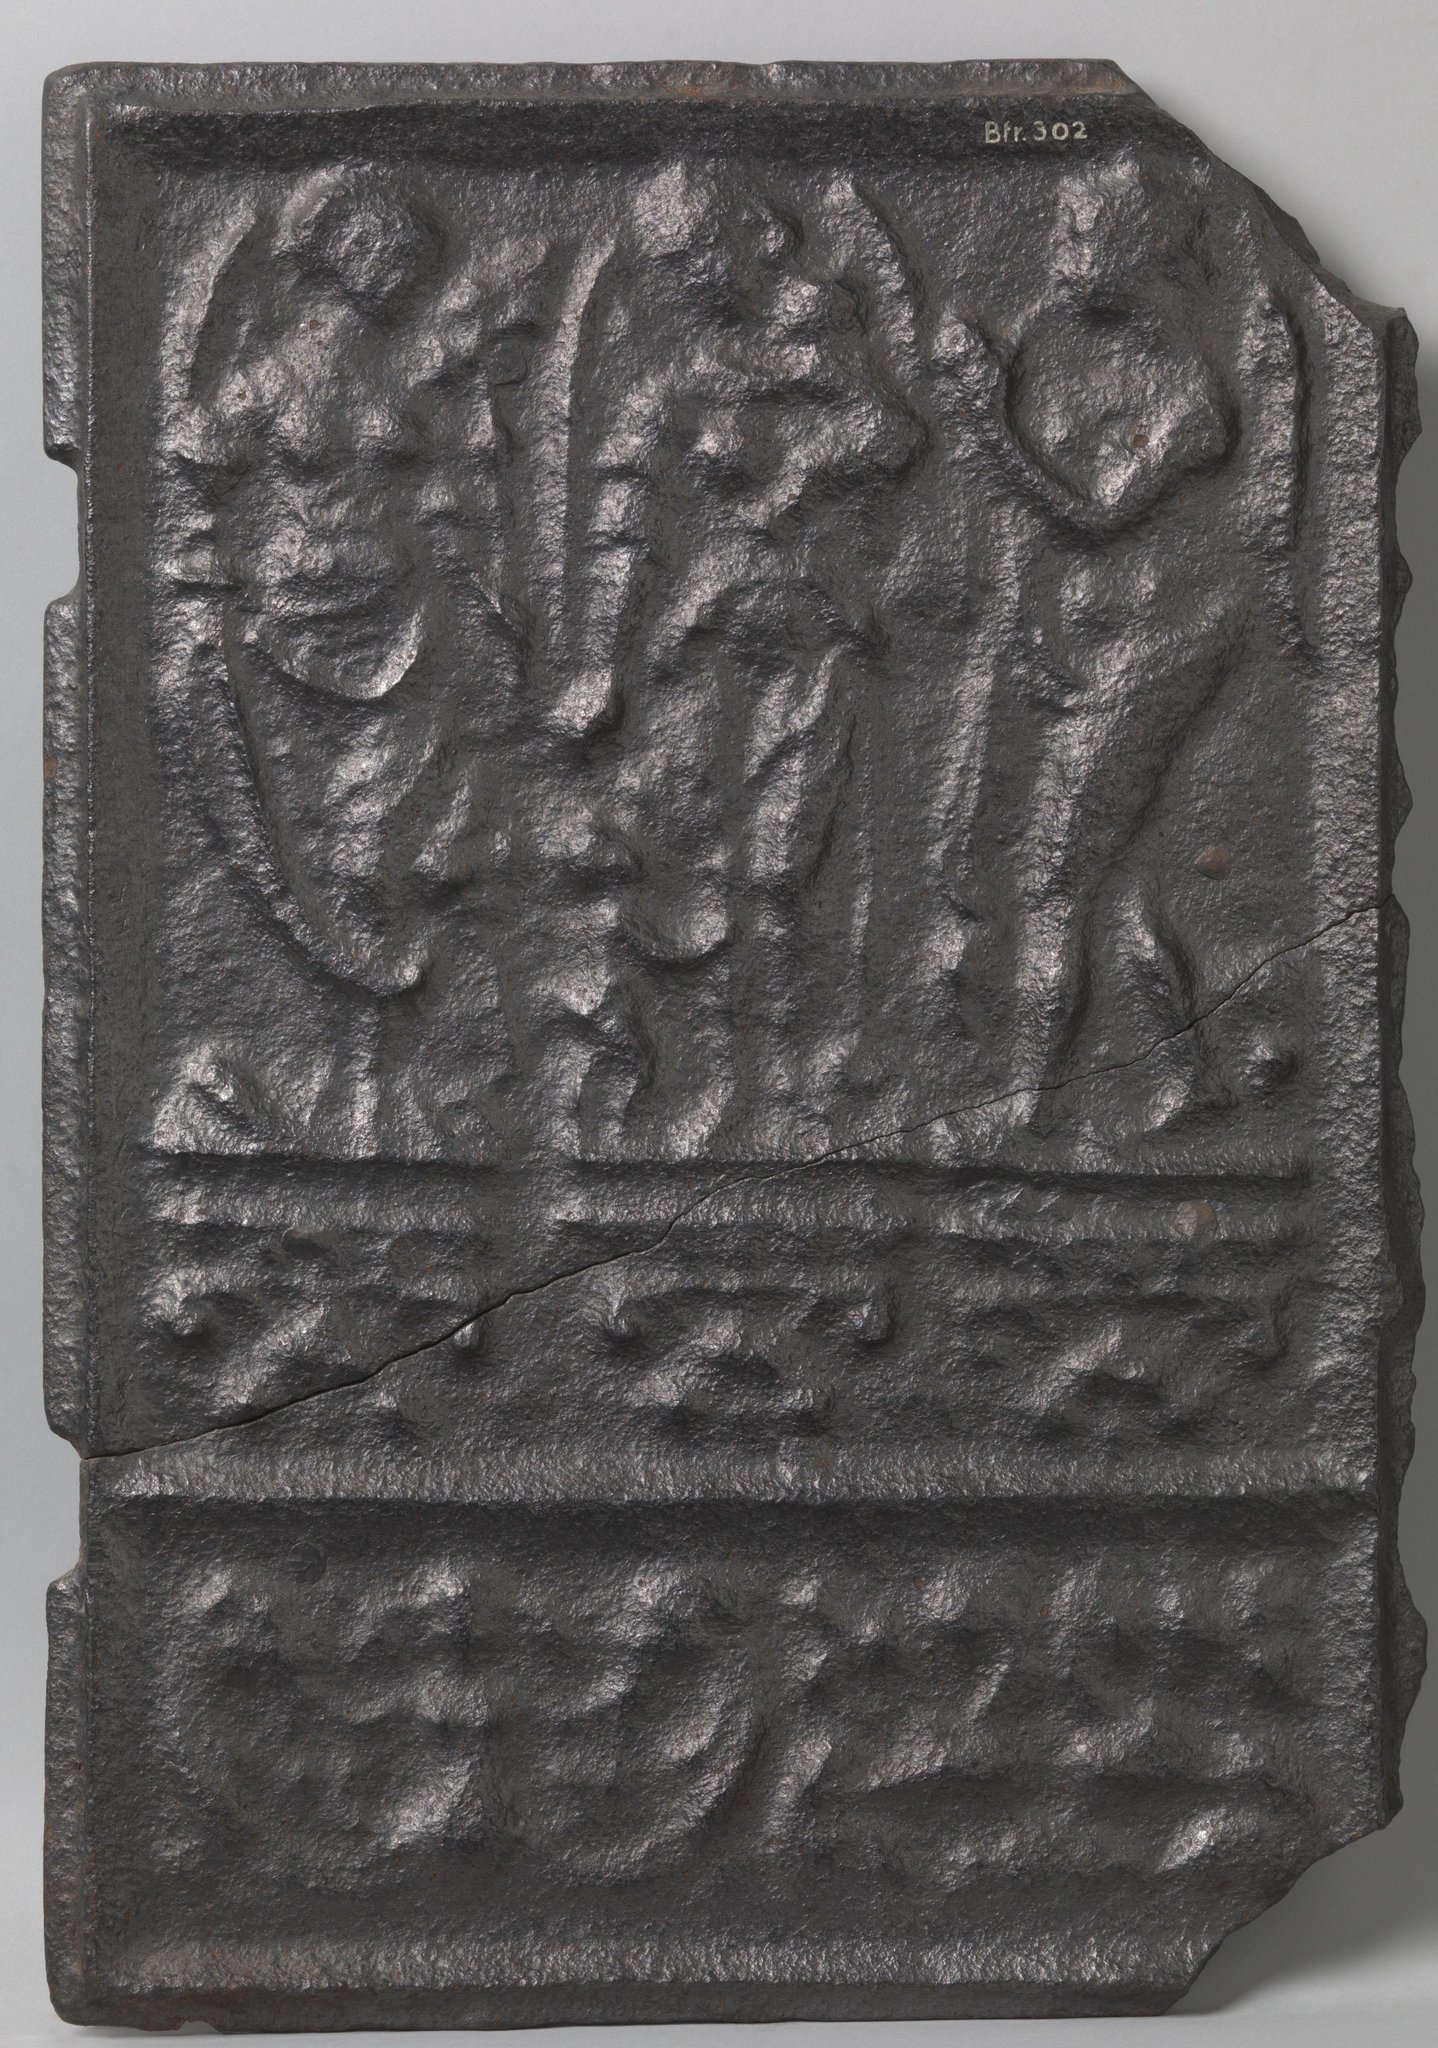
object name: stove plate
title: Kachelplaat met drie gevleugelde vrouwen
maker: Anonymous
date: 1550-1600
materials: iron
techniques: casting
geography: germany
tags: the three theological virtues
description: Kachelplaat van gietijzer, verdeeld in twee zones. In de bovenste zone zijn drie gevleugelde vrouwen afgebeeld op een console. Mogelijk betreffen zij de drie theologische deugden, met Liefde in het midden met twee kinderen bij zich. In de onderste zone is links een zeemeermin (?) afgebeeld met twee staarten. Het symmetrische motief rechts is onduidelijk.